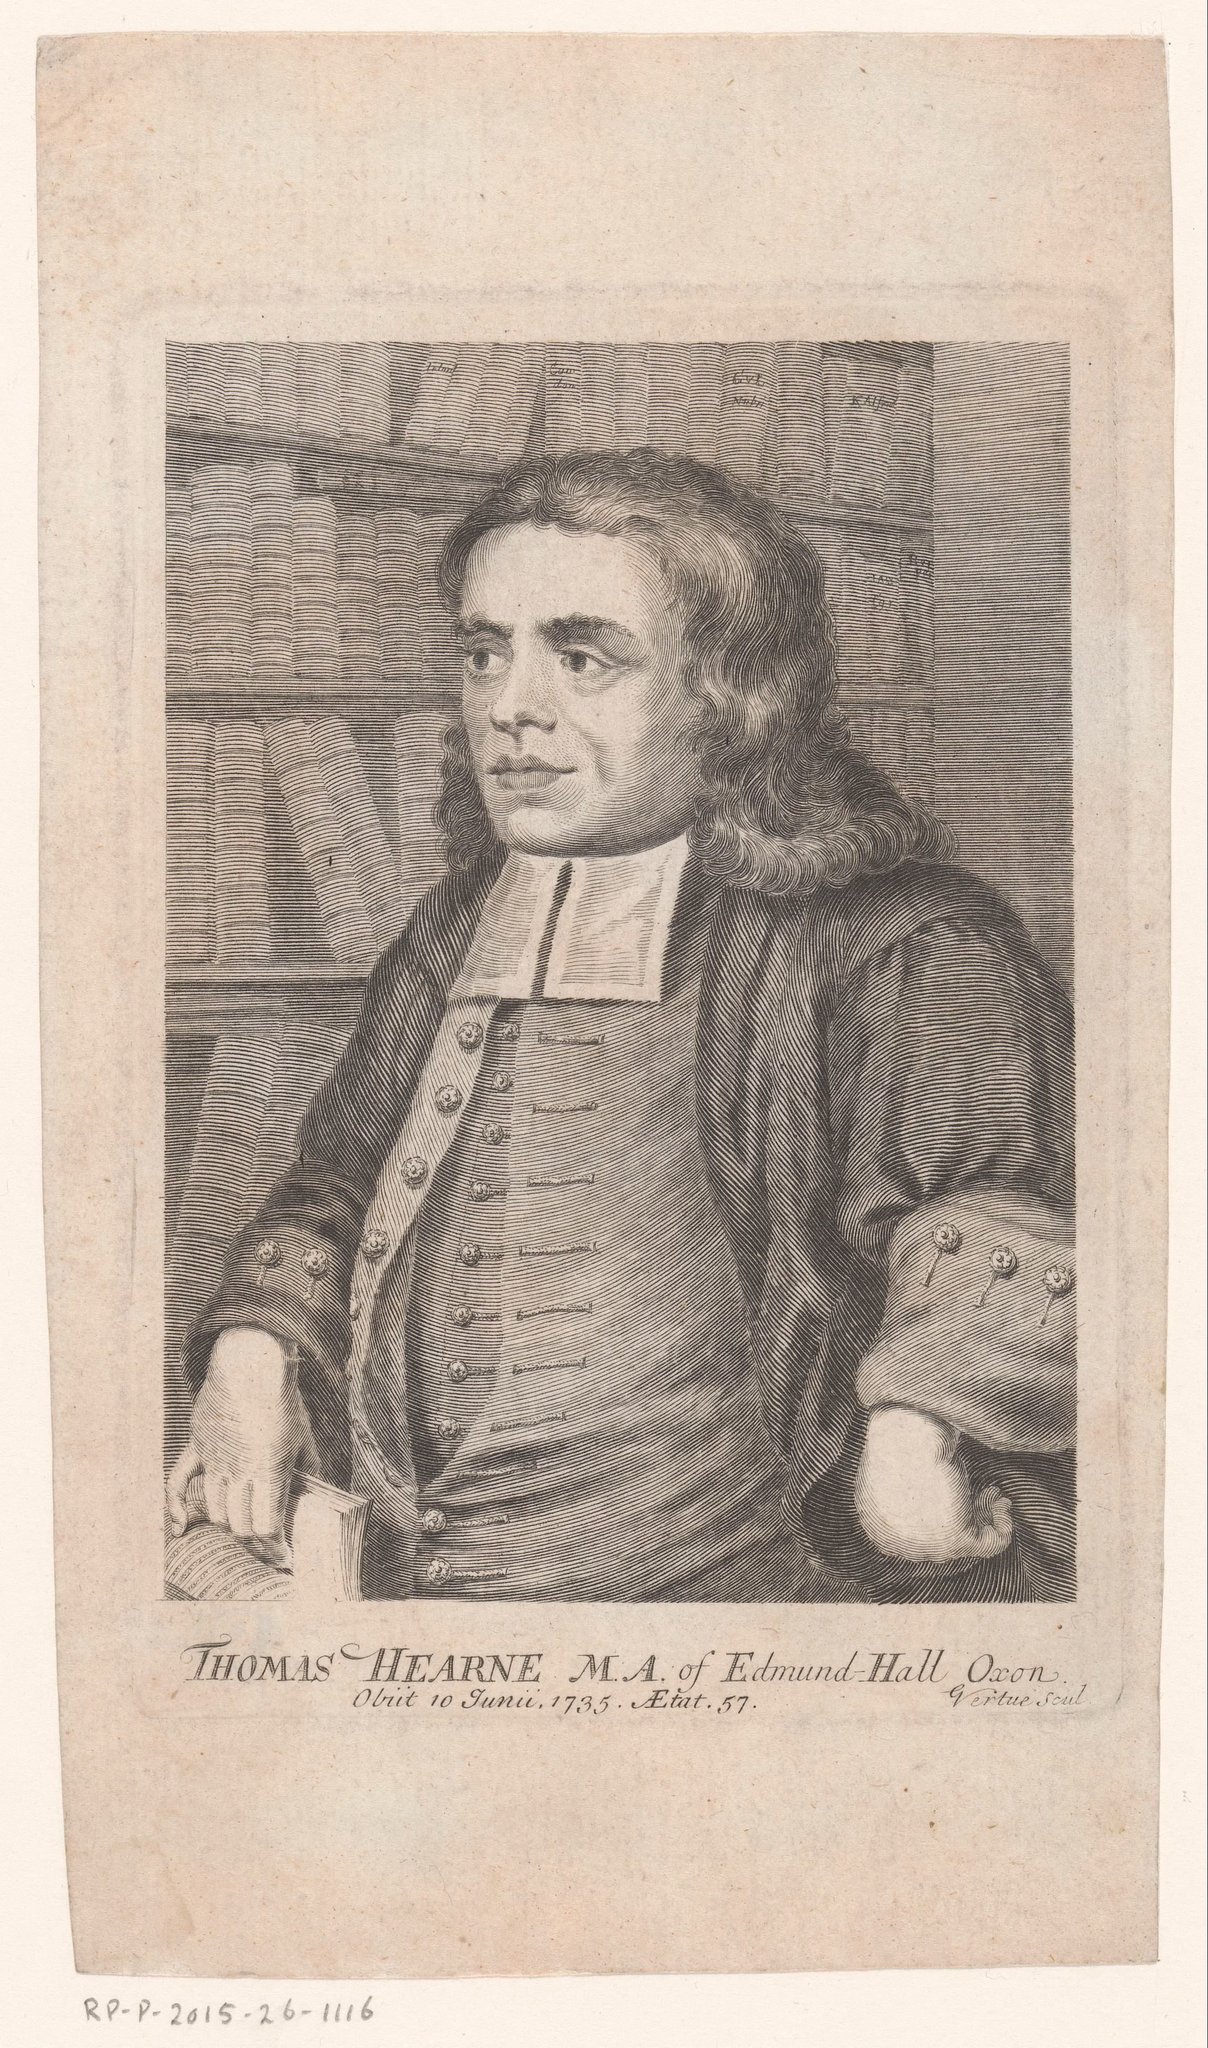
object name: print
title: Titelpagina voor: The Life of Thomas Hearne, 1772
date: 1731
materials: paper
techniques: engraving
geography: oxford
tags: london, print maker, draughtsman, thomas hearne, scholar in his study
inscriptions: collector's mark: Lugt 4779, collector's mark: Lugt 2228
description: De eerste staat van deze prent werd gebruikt als titelpagina voor: Hearne, Thomas. A vindication of those who take the oath of allegiance. S.l., 1731. Op de tweede staat van deze prent is de verwijzing naar de eed verwijderd van het boek dat Hearne in zijn rechterhand heeft. Deze prent werd gebruikt als titelpagina voor: The Life of Thomas Hearne of St. Edmund's Hall. Oxford: Clarendon Press, [1772].